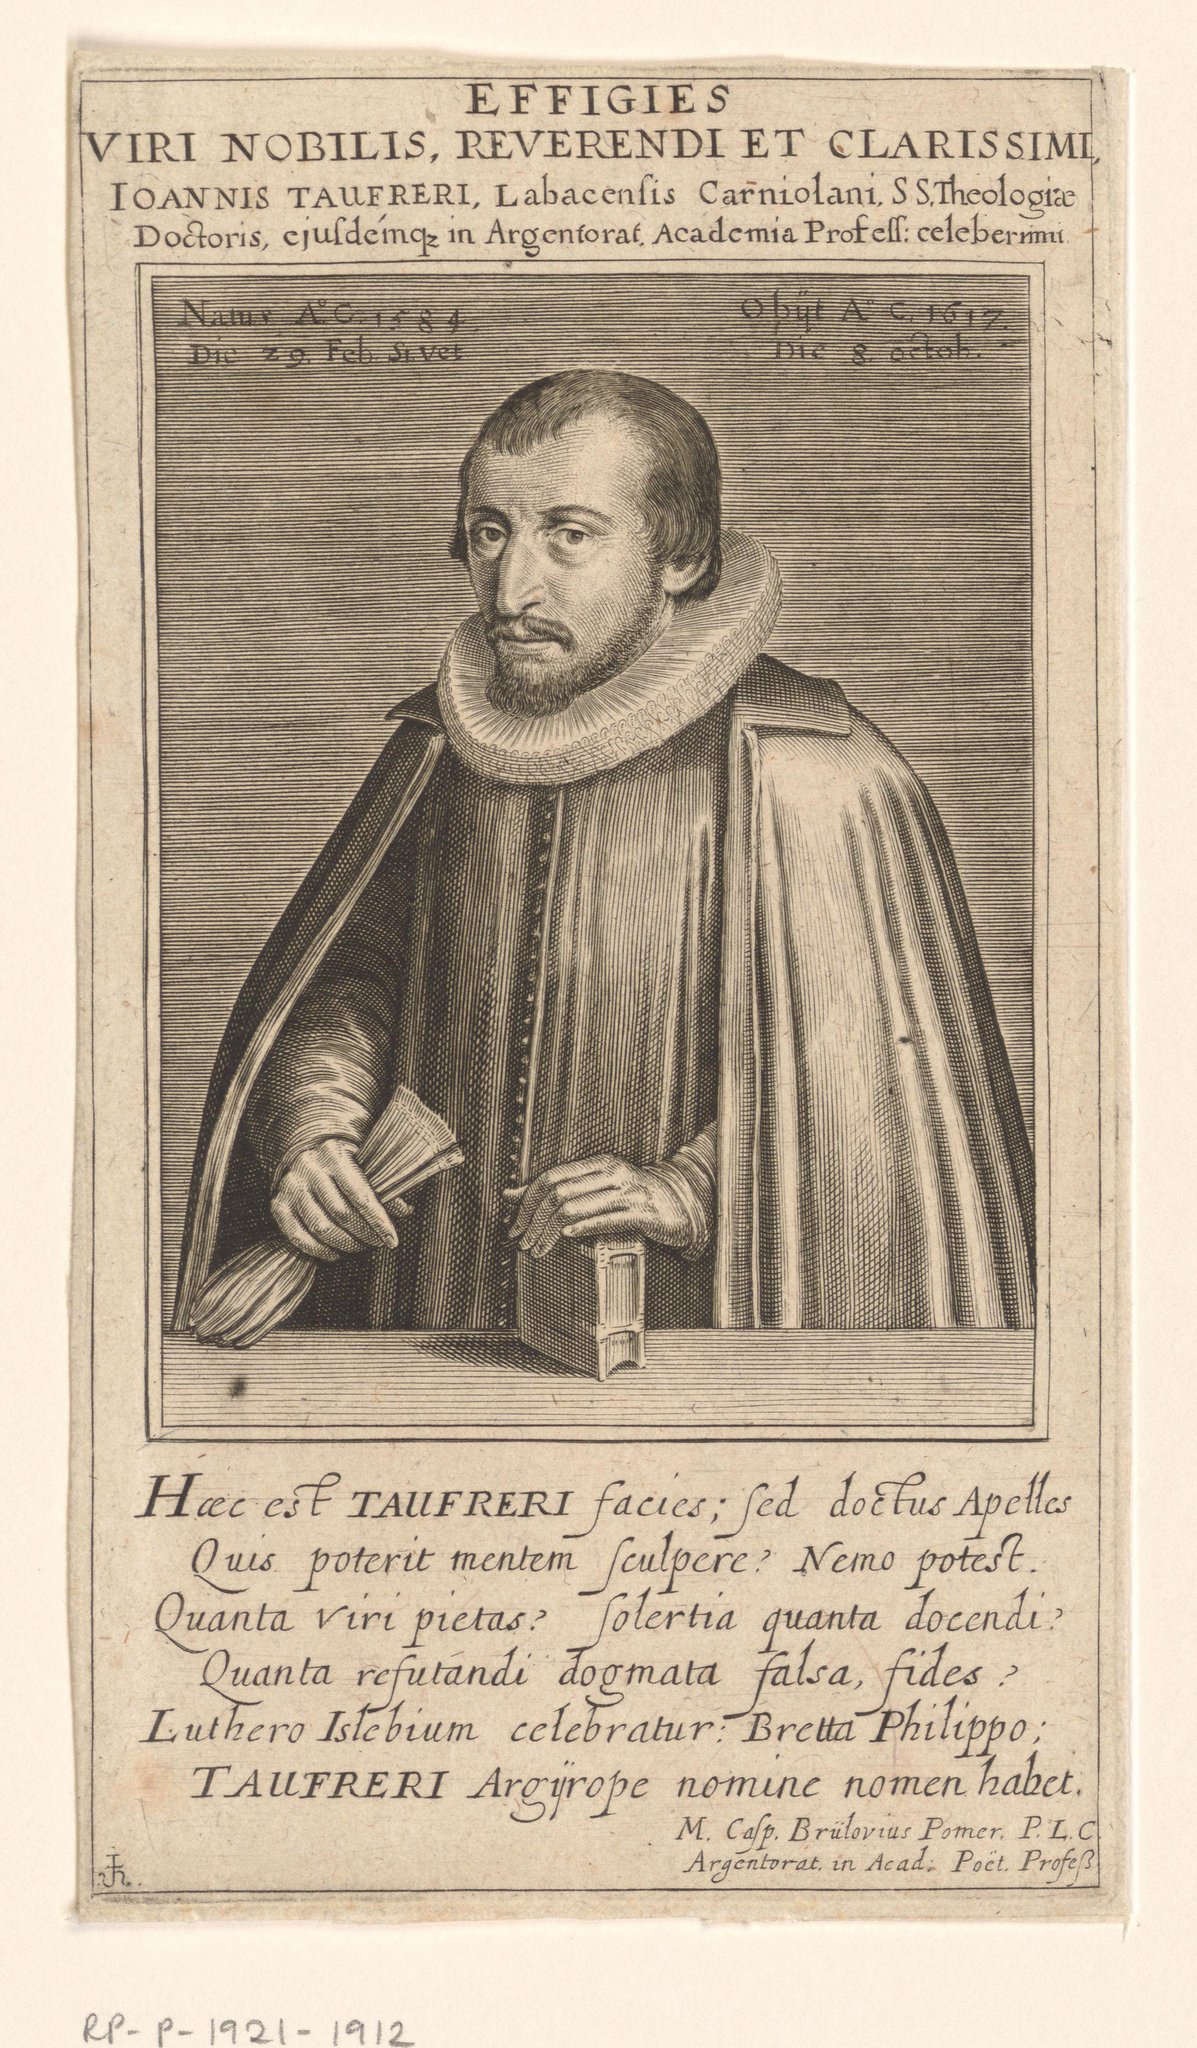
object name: print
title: Portret van Johann Taufrer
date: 1617-1645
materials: paper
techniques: engraving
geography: straatsburg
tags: theologian, historical persons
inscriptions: collector's mark: Lugt 2233